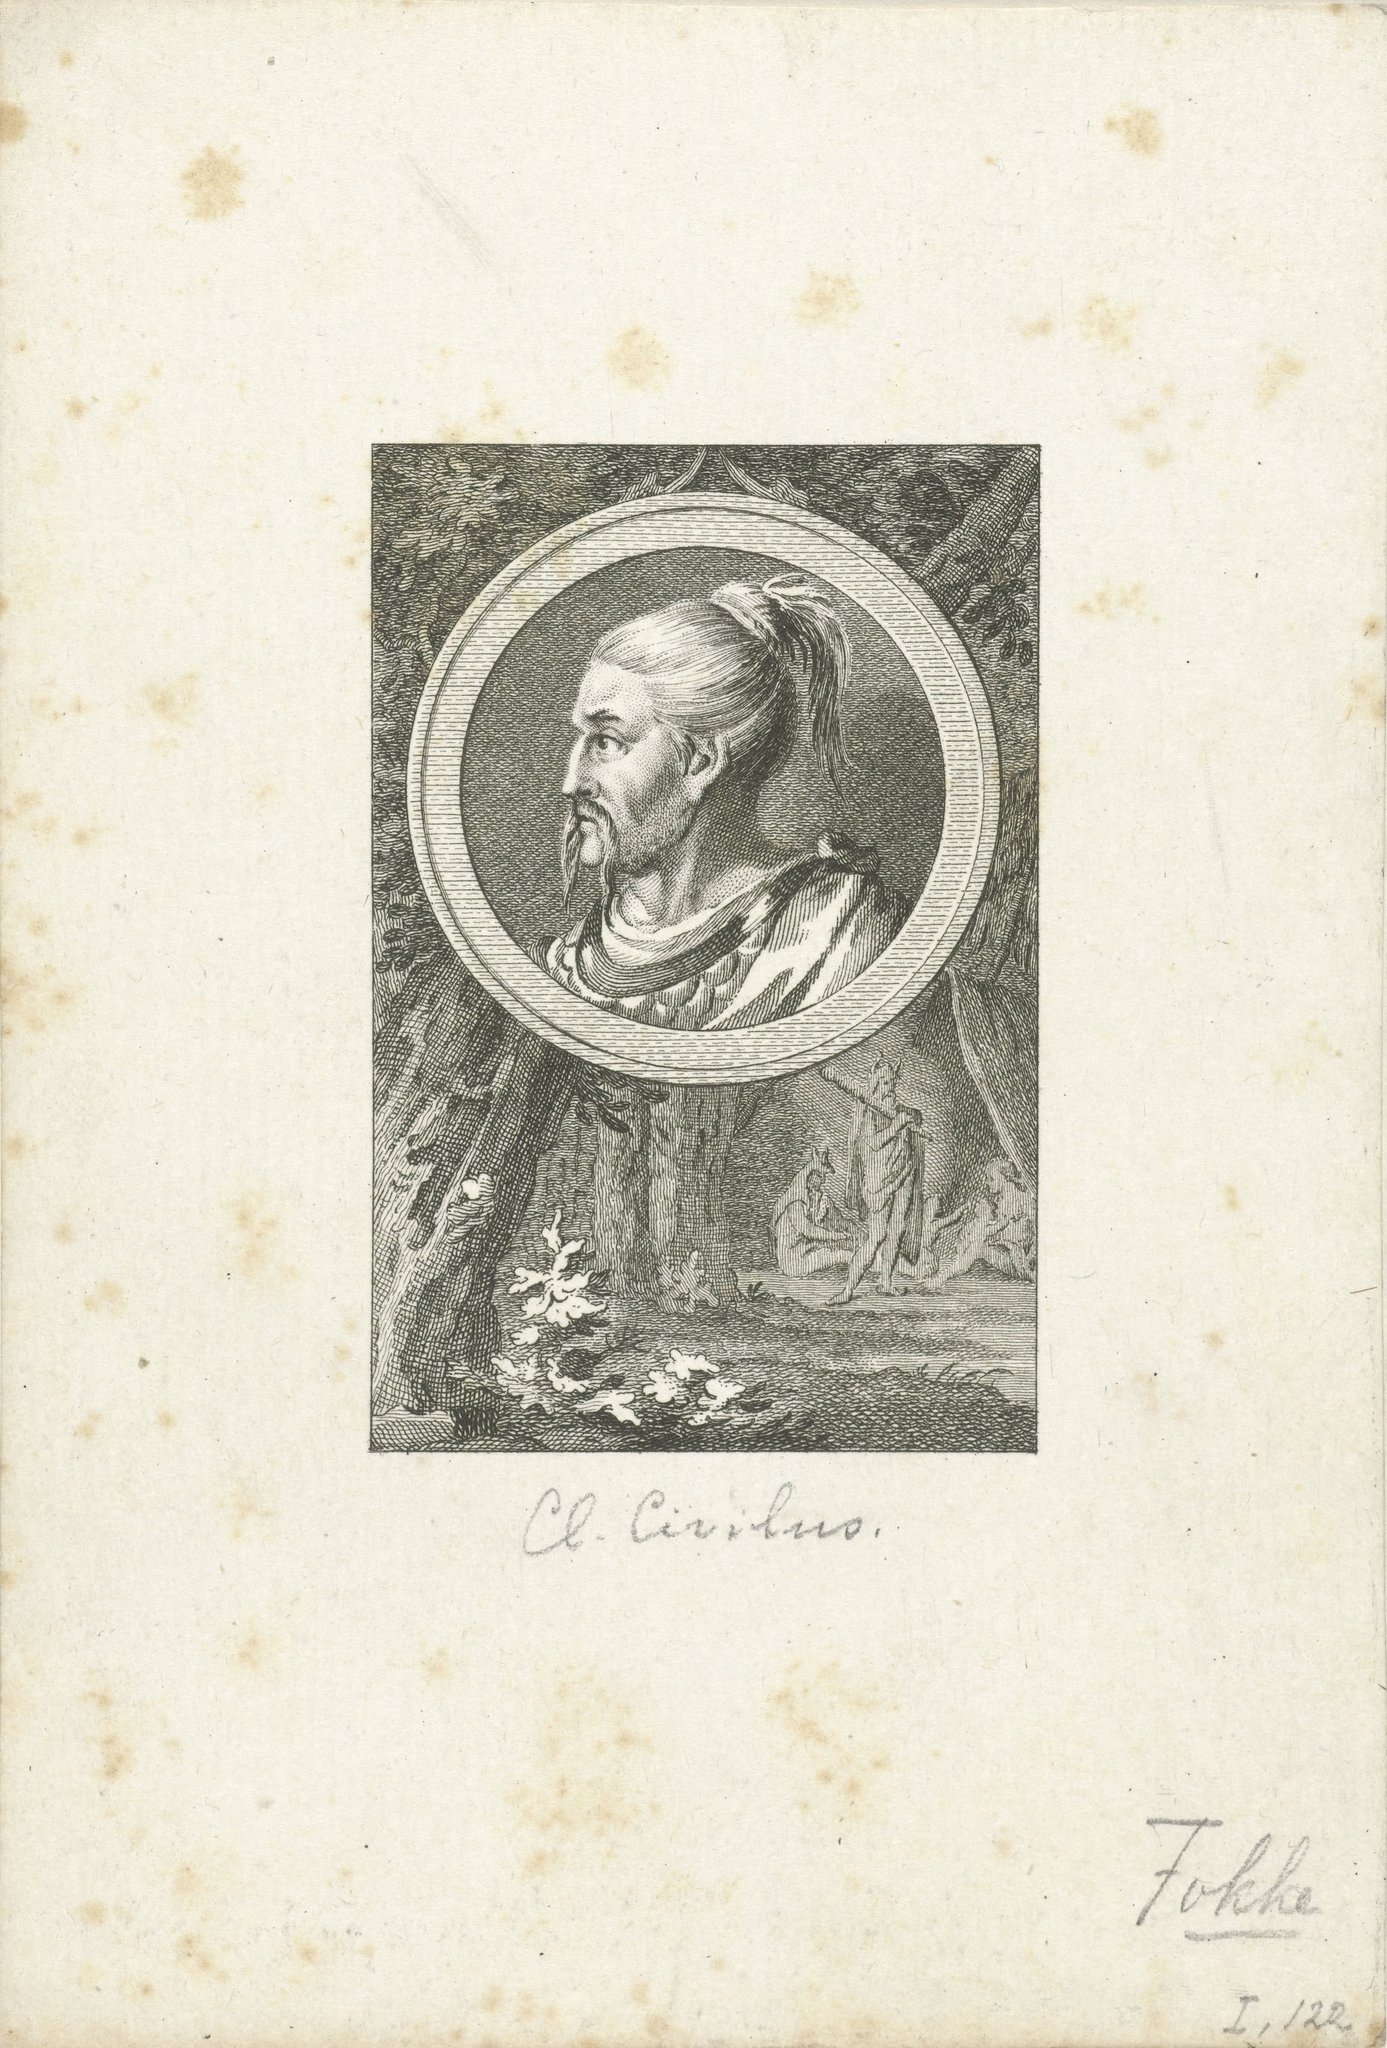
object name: print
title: Medaille met portret van Claudius Civilus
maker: simon fokke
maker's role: draughtsman, print maker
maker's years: 1712-1784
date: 1722-1784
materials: paper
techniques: etching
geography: amsterdam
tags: (story of) julius claudius civilis - portrait of person from classical history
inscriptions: collector's mark: Lugt 2228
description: Kop van Claudius Civilus, naar links, in medaille. Op de achtergrond een bos met figuren.